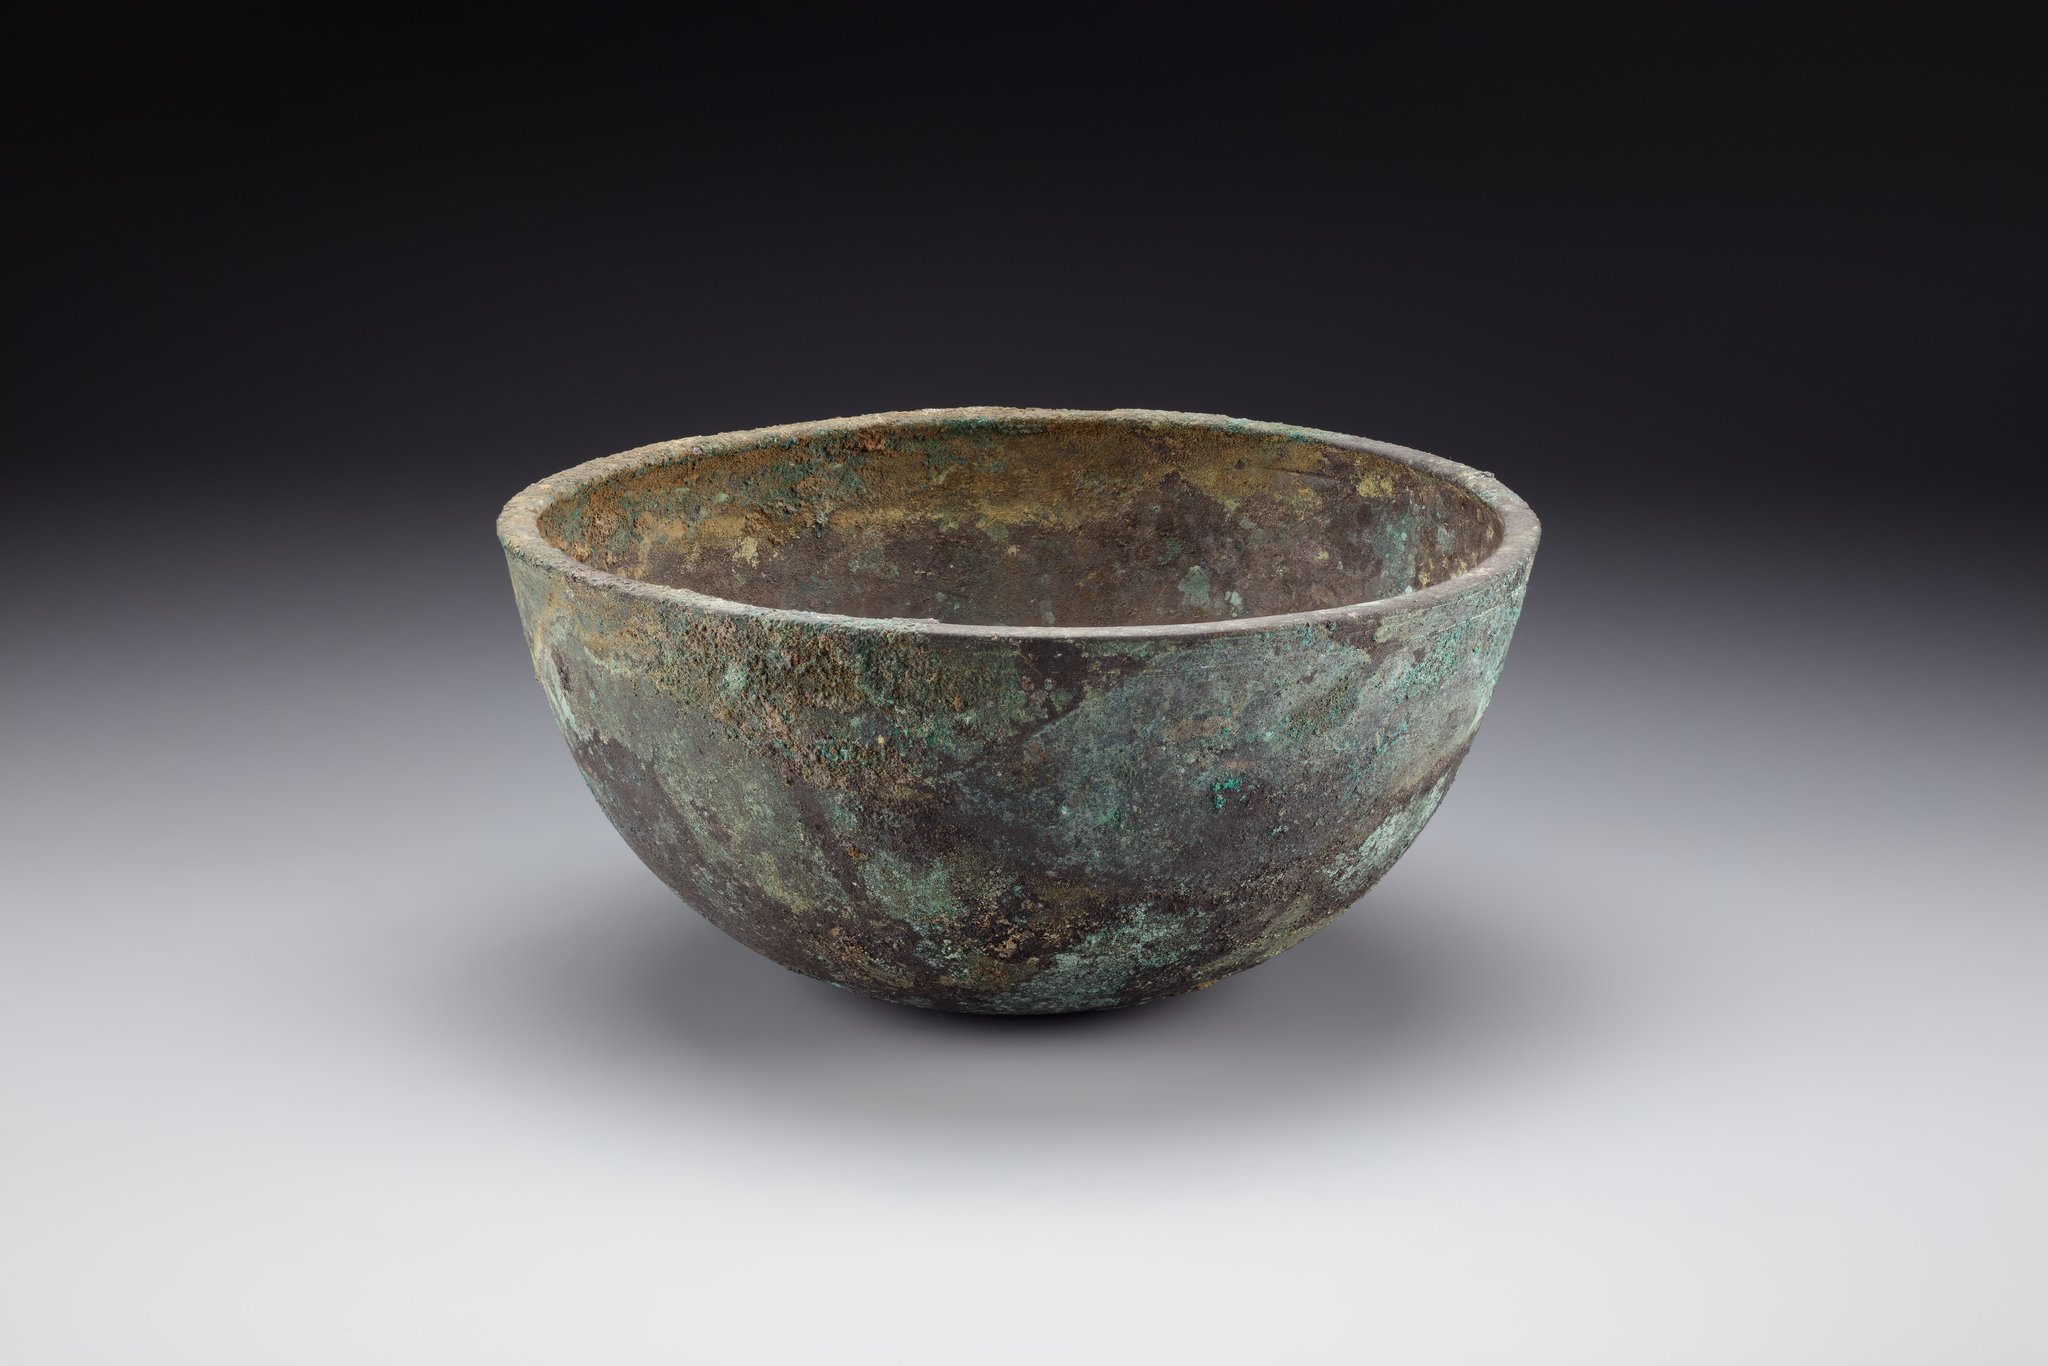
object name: bowl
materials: copper alloy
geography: nubia